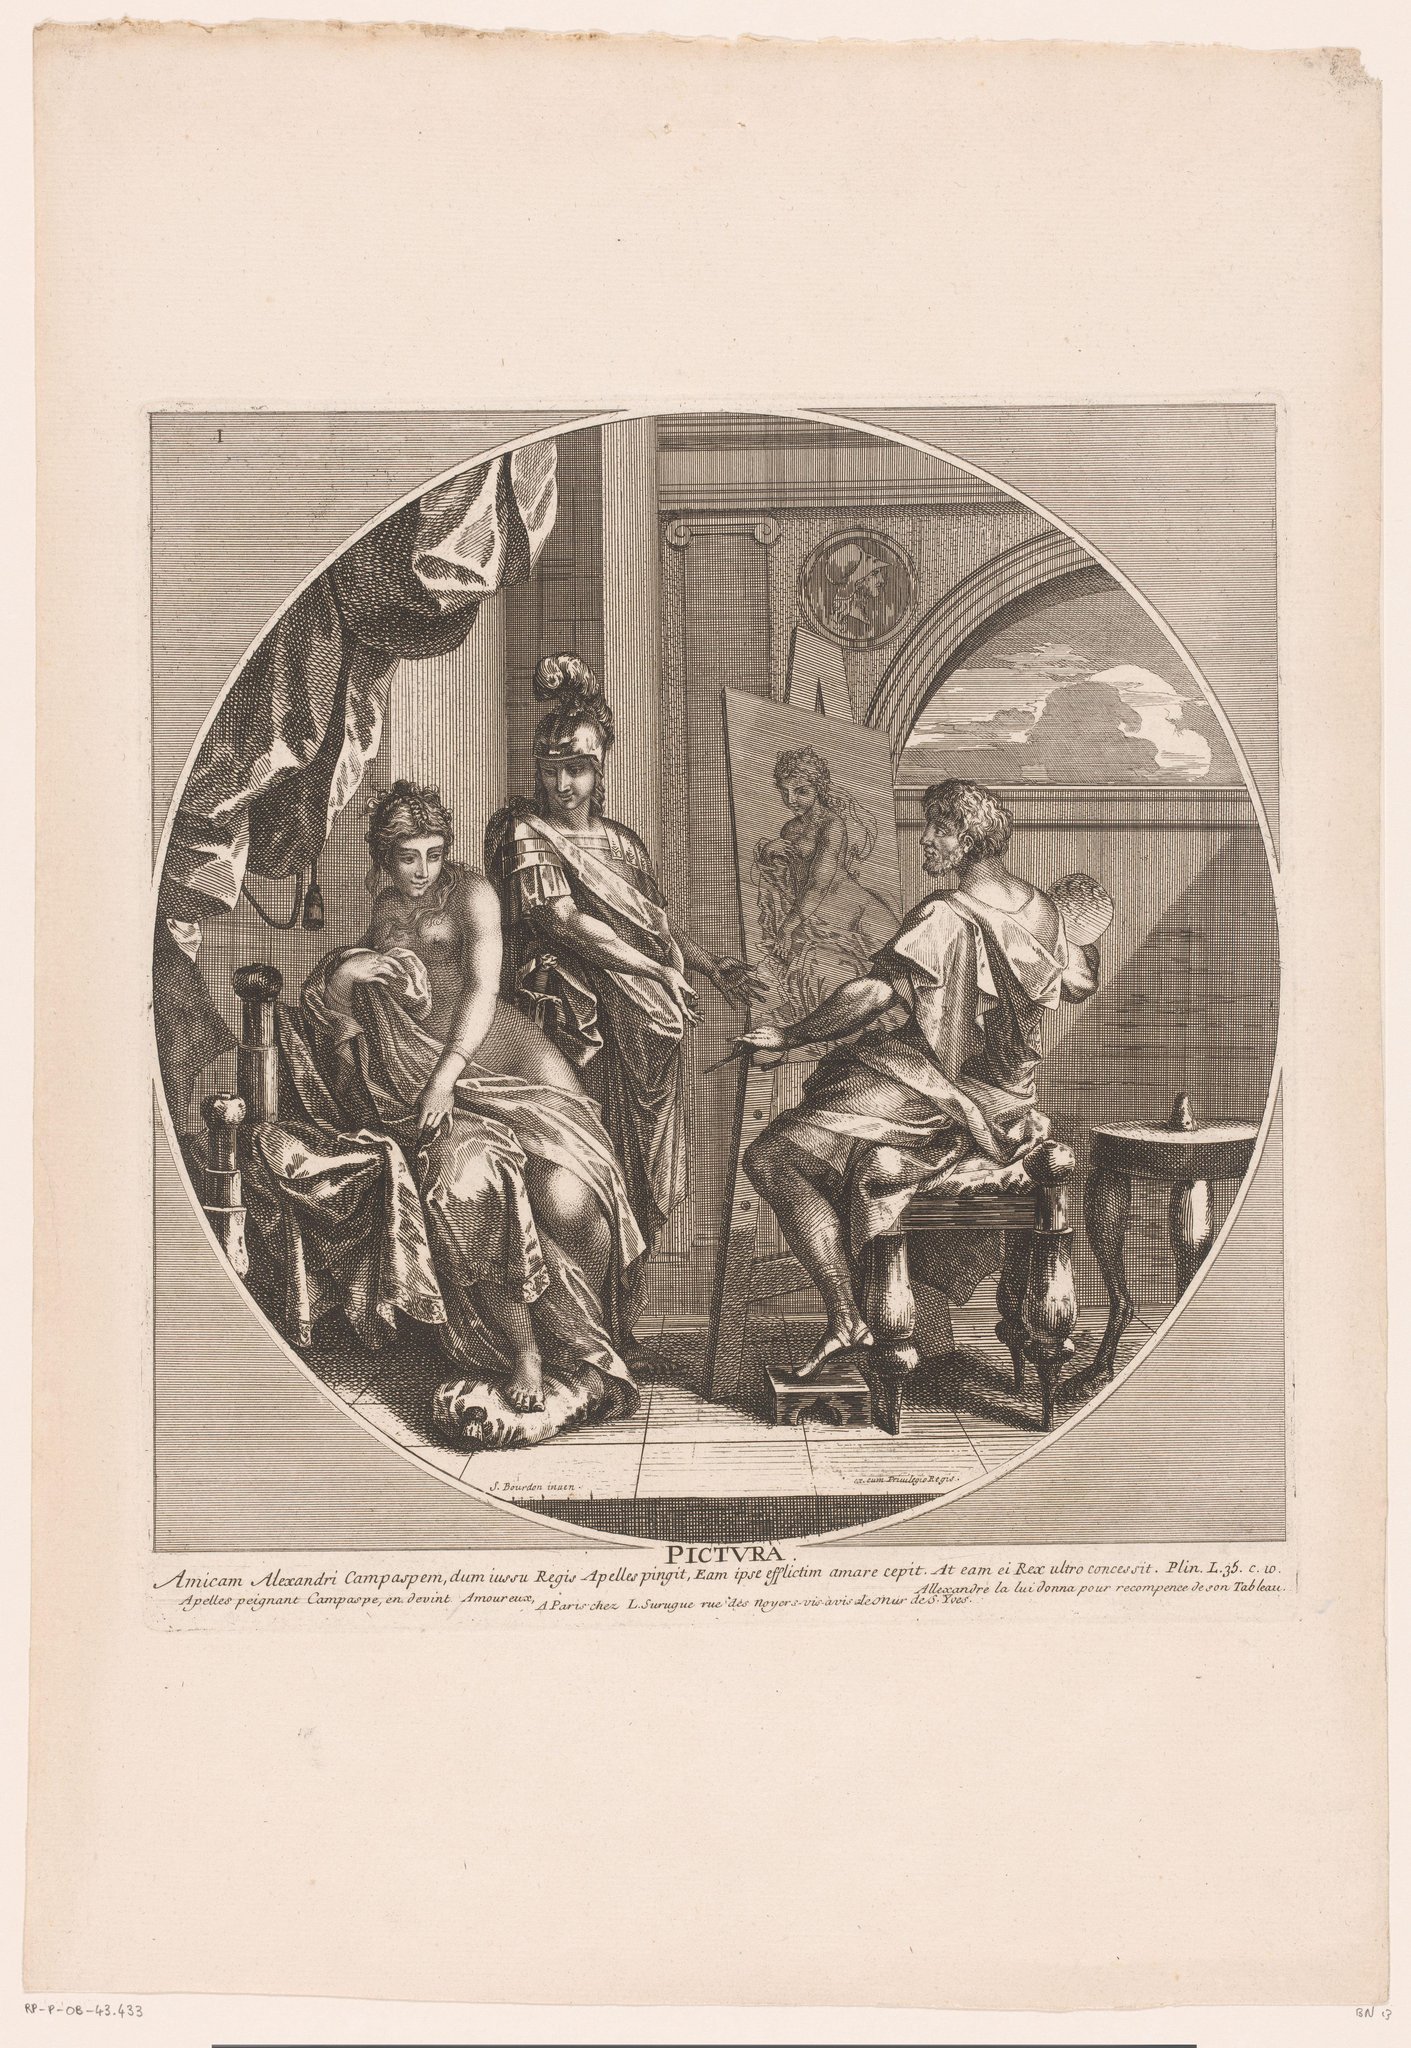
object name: print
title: Les Vertus et les Arts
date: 1663-1738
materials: paper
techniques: engraving, etching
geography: france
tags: painter, apelles, 'pictura', symbolic representations, allegories and emblems ~ painting; 'pittura' (ripa), historical persons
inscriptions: collector's mark: Lugt 2228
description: Maakt deel uit van een veertiendelige serie opgedeeld in twee reeksen, met als onderwerp de zeven vrije kunsten en deugden naar schilderijen door Sébastien Bourdon. De schilderijen werden in 1663 vervaardigd voor de Grande Galerie van het Hôtel de Bretonvilliers te Parijs.